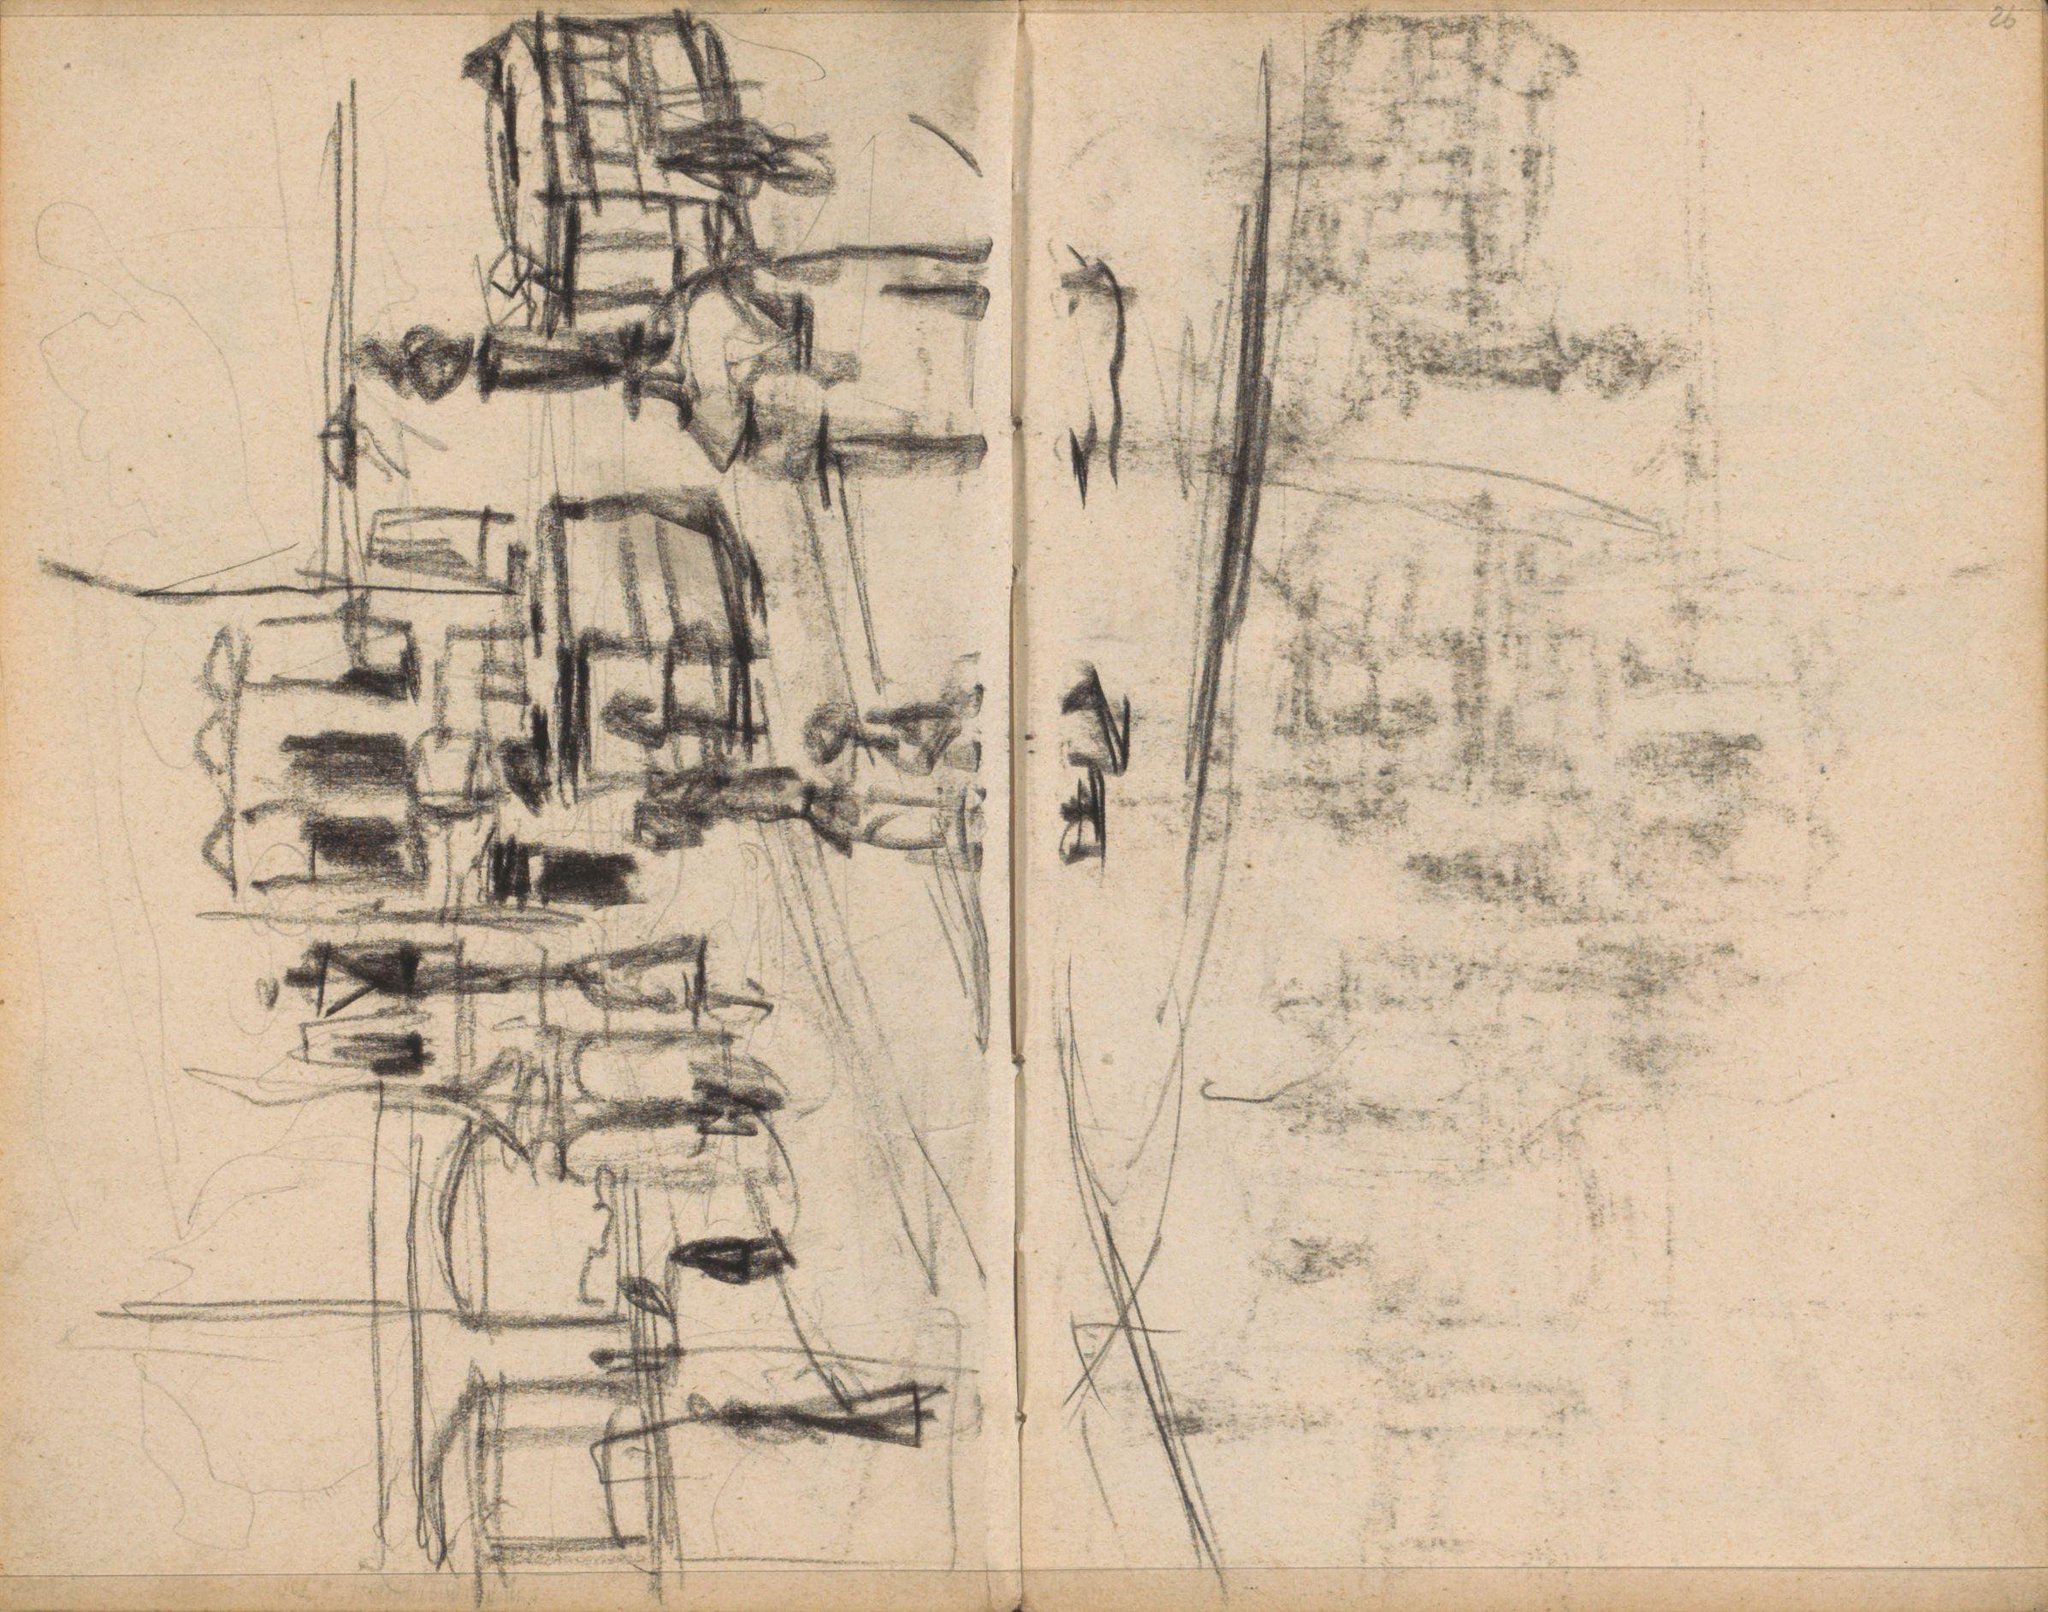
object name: sketchbook leaf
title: Gezicht in Amsterdam, mogelijk de Dam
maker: george hendrik breitner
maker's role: draughtsman, painter, print maker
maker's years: 1857-1923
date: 1902-1914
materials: chalk, paper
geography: amsterdam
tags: urban housing, tram, monument, statue (+ city(-scape) with figures, staffage)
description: Gezicht in Amsterdam, mogelijk de Dam. Vooraan trams. Rechts een standbeeld, mogelijk Naatje. Pagina 25 en pagina 26 uit een schetsboek met 46 bladen vervaardigd te Noord-Holland en Utrecht.